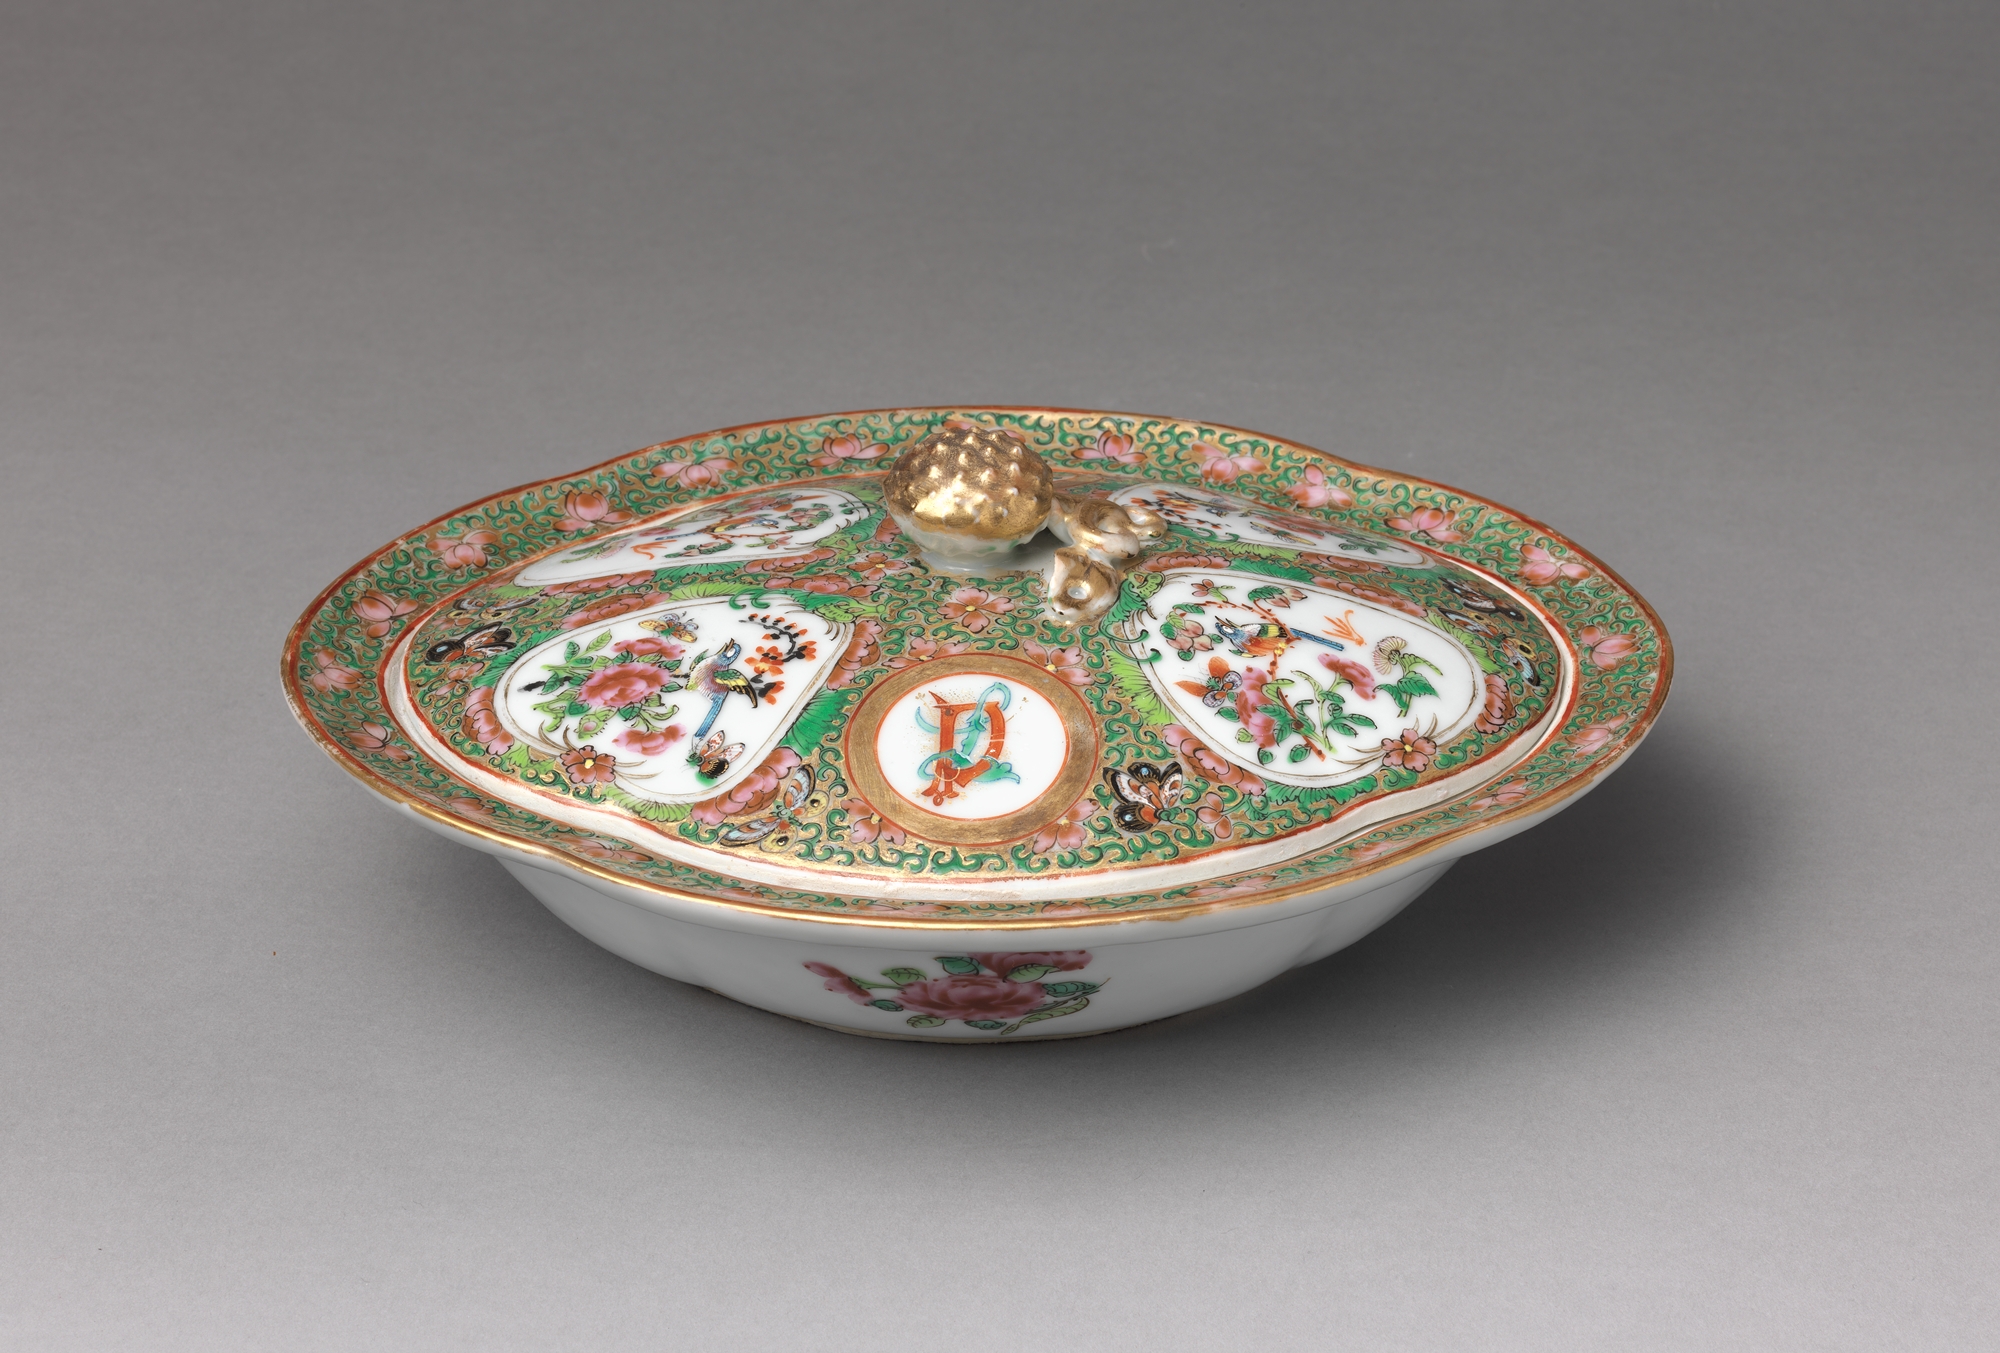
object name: serving dish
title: Covered Serving Dish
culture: chinese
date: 1860-1866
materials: porcelain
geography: china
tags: birds,butterflies,flowers